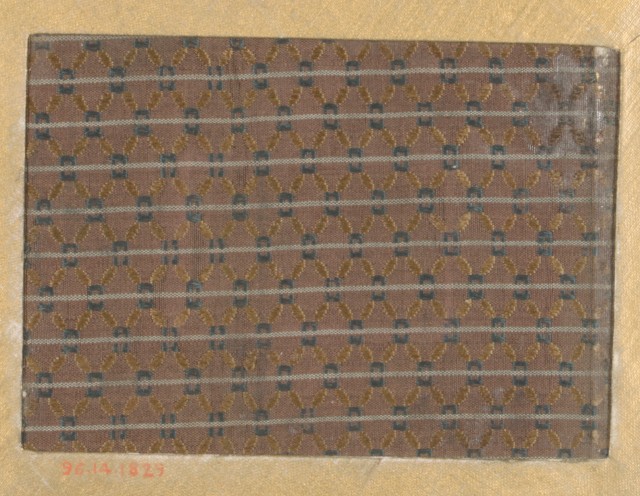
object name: piece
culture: japanese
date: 1701-1900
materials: silk